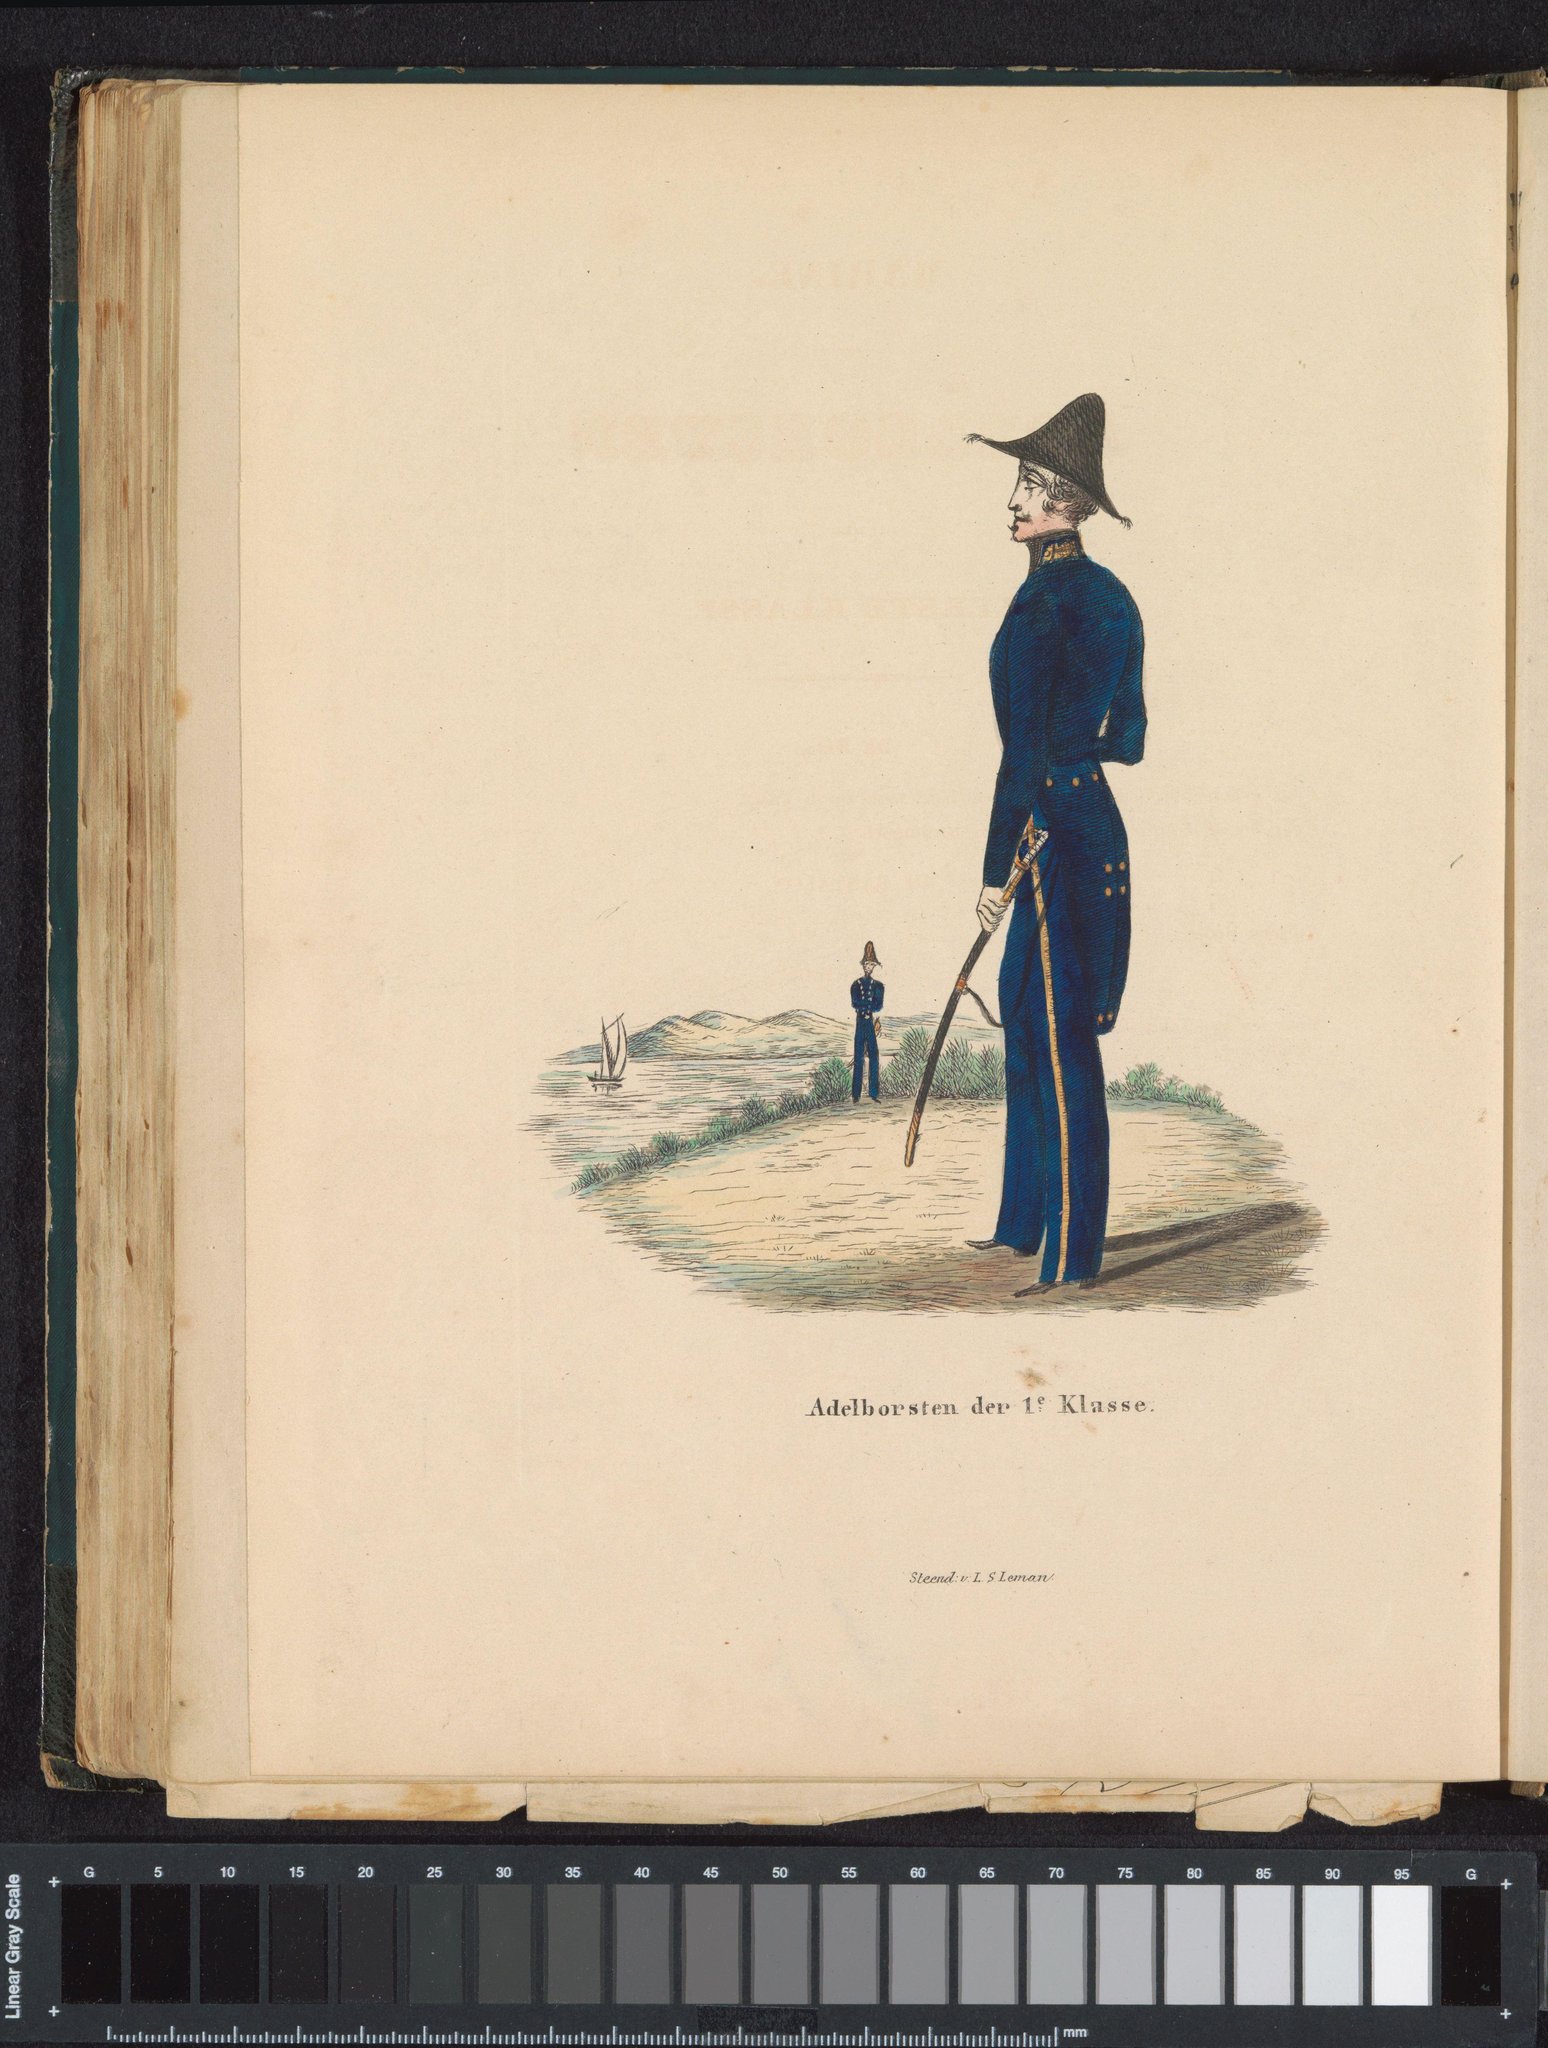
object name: print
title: Uniform voor adelborsten eerste klasse van de Marine, 1845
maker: louis salomon leman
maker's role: steendrukker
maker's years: 1818-1889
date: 1845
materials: paper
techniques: hand coloring, lithograph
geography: netherlands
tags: (military) uniforms, netherlands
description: Uniform voor adelborsten eerste klasse van de Marine. Illustratie in een boek uit 1845 over de uniformen en kledingstukken van de Nederlandse land-, zeemacht en schutterijen in Nederland en in de overzeese gebiedsdelen.